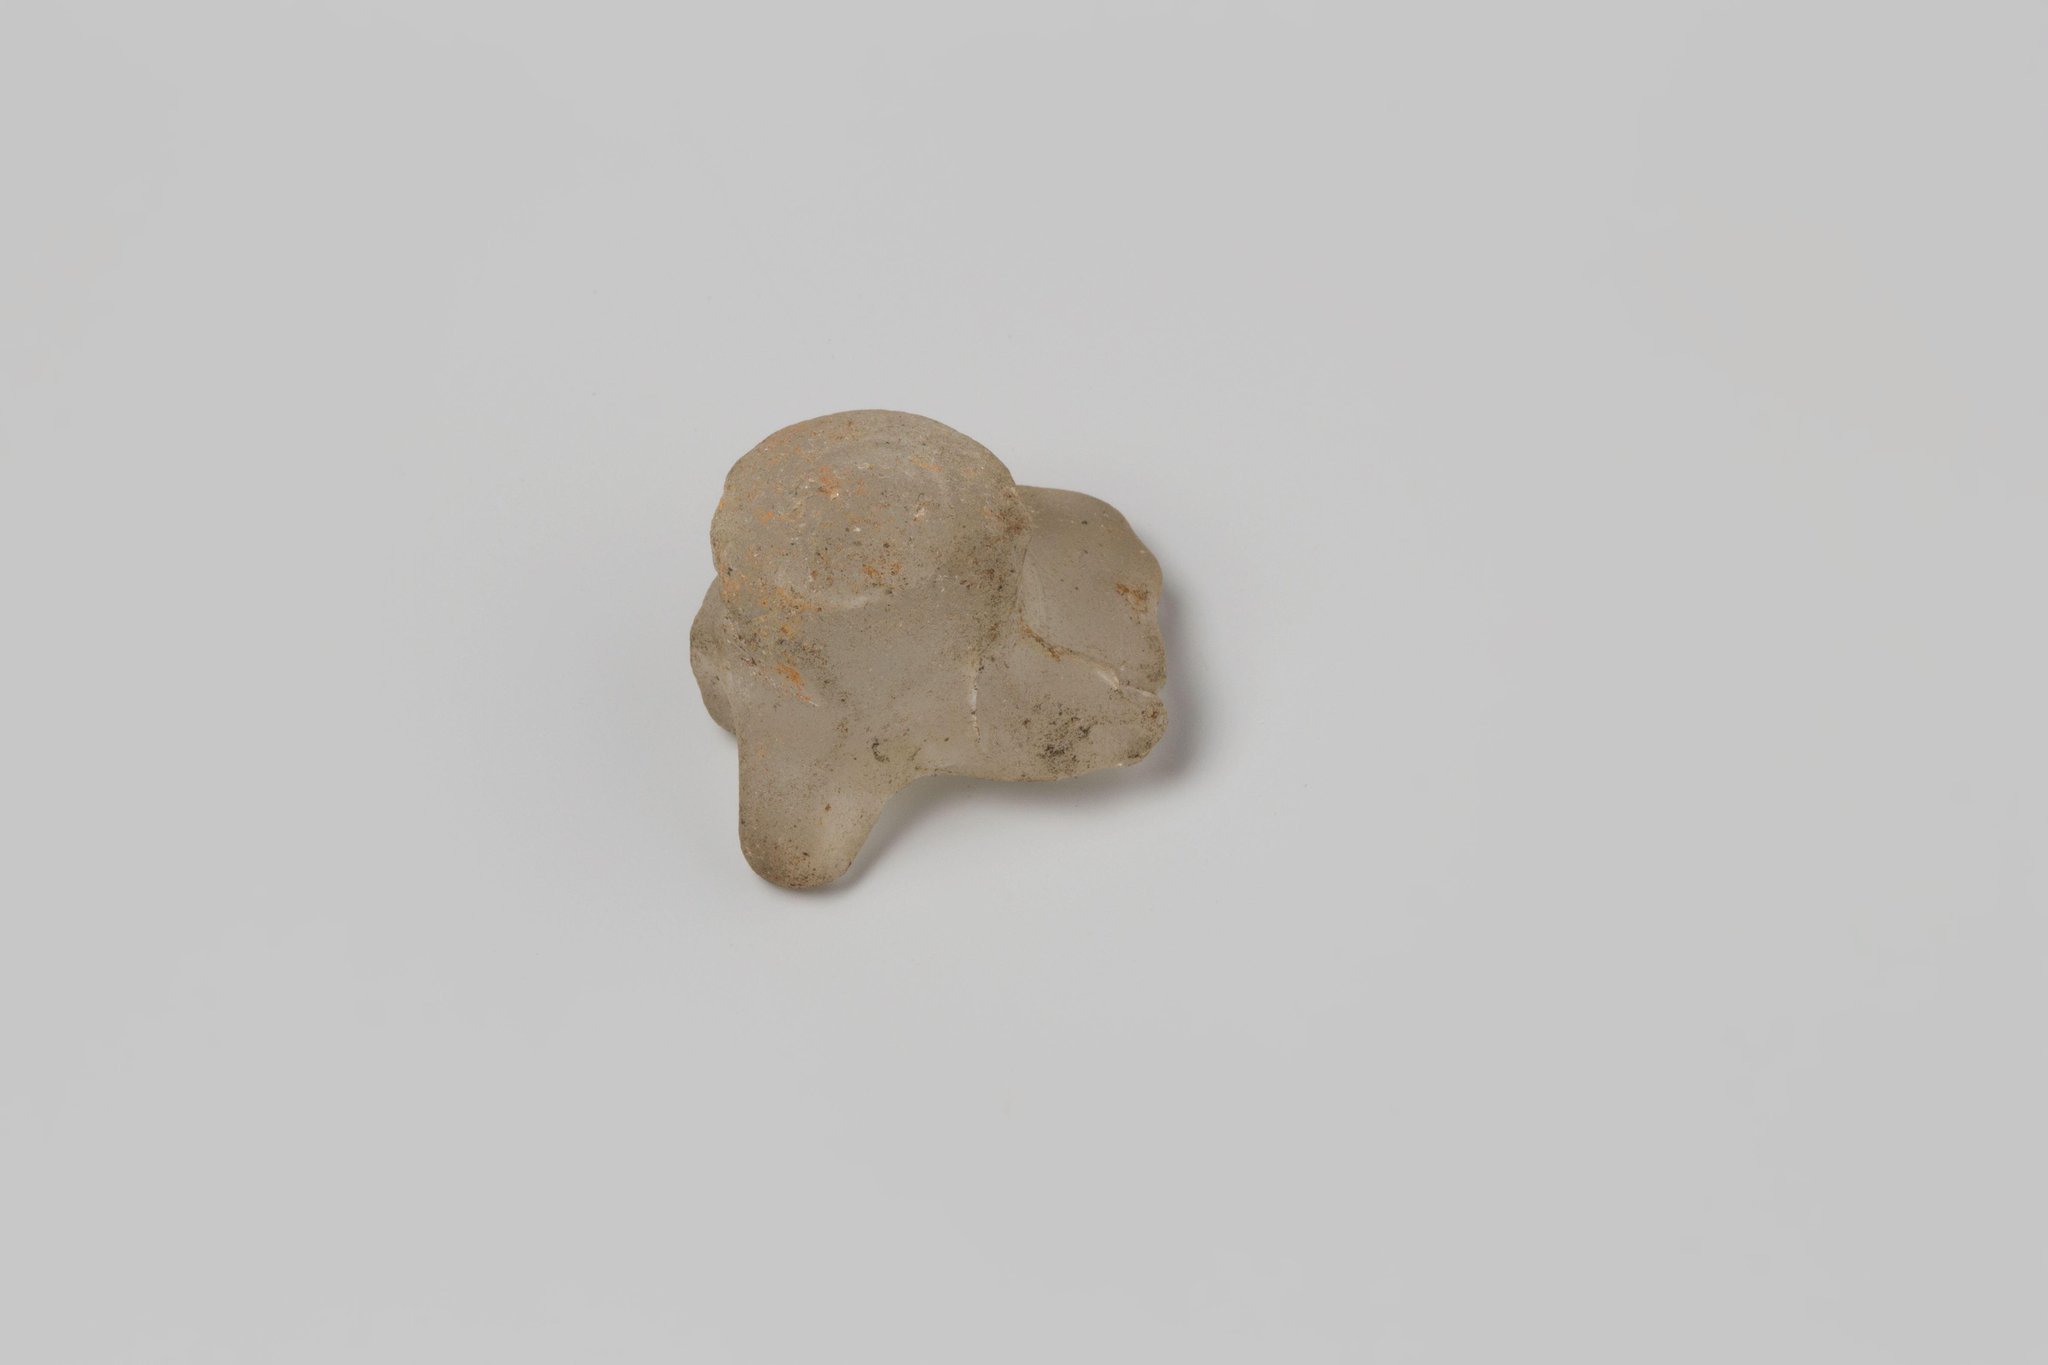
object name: drinking glass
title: Fragment kom van een fluitglas uit het wrak van de Oost-Indiëvaarder Hollandia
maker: Anonymous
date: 1700-1743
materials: glass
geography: netherlands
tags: verenigde oostindische compagnie, hollandia (schip), annet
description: Glass, stem glass, bowl; fragment of base, circular, curved, plain with knop underneath, eroded.